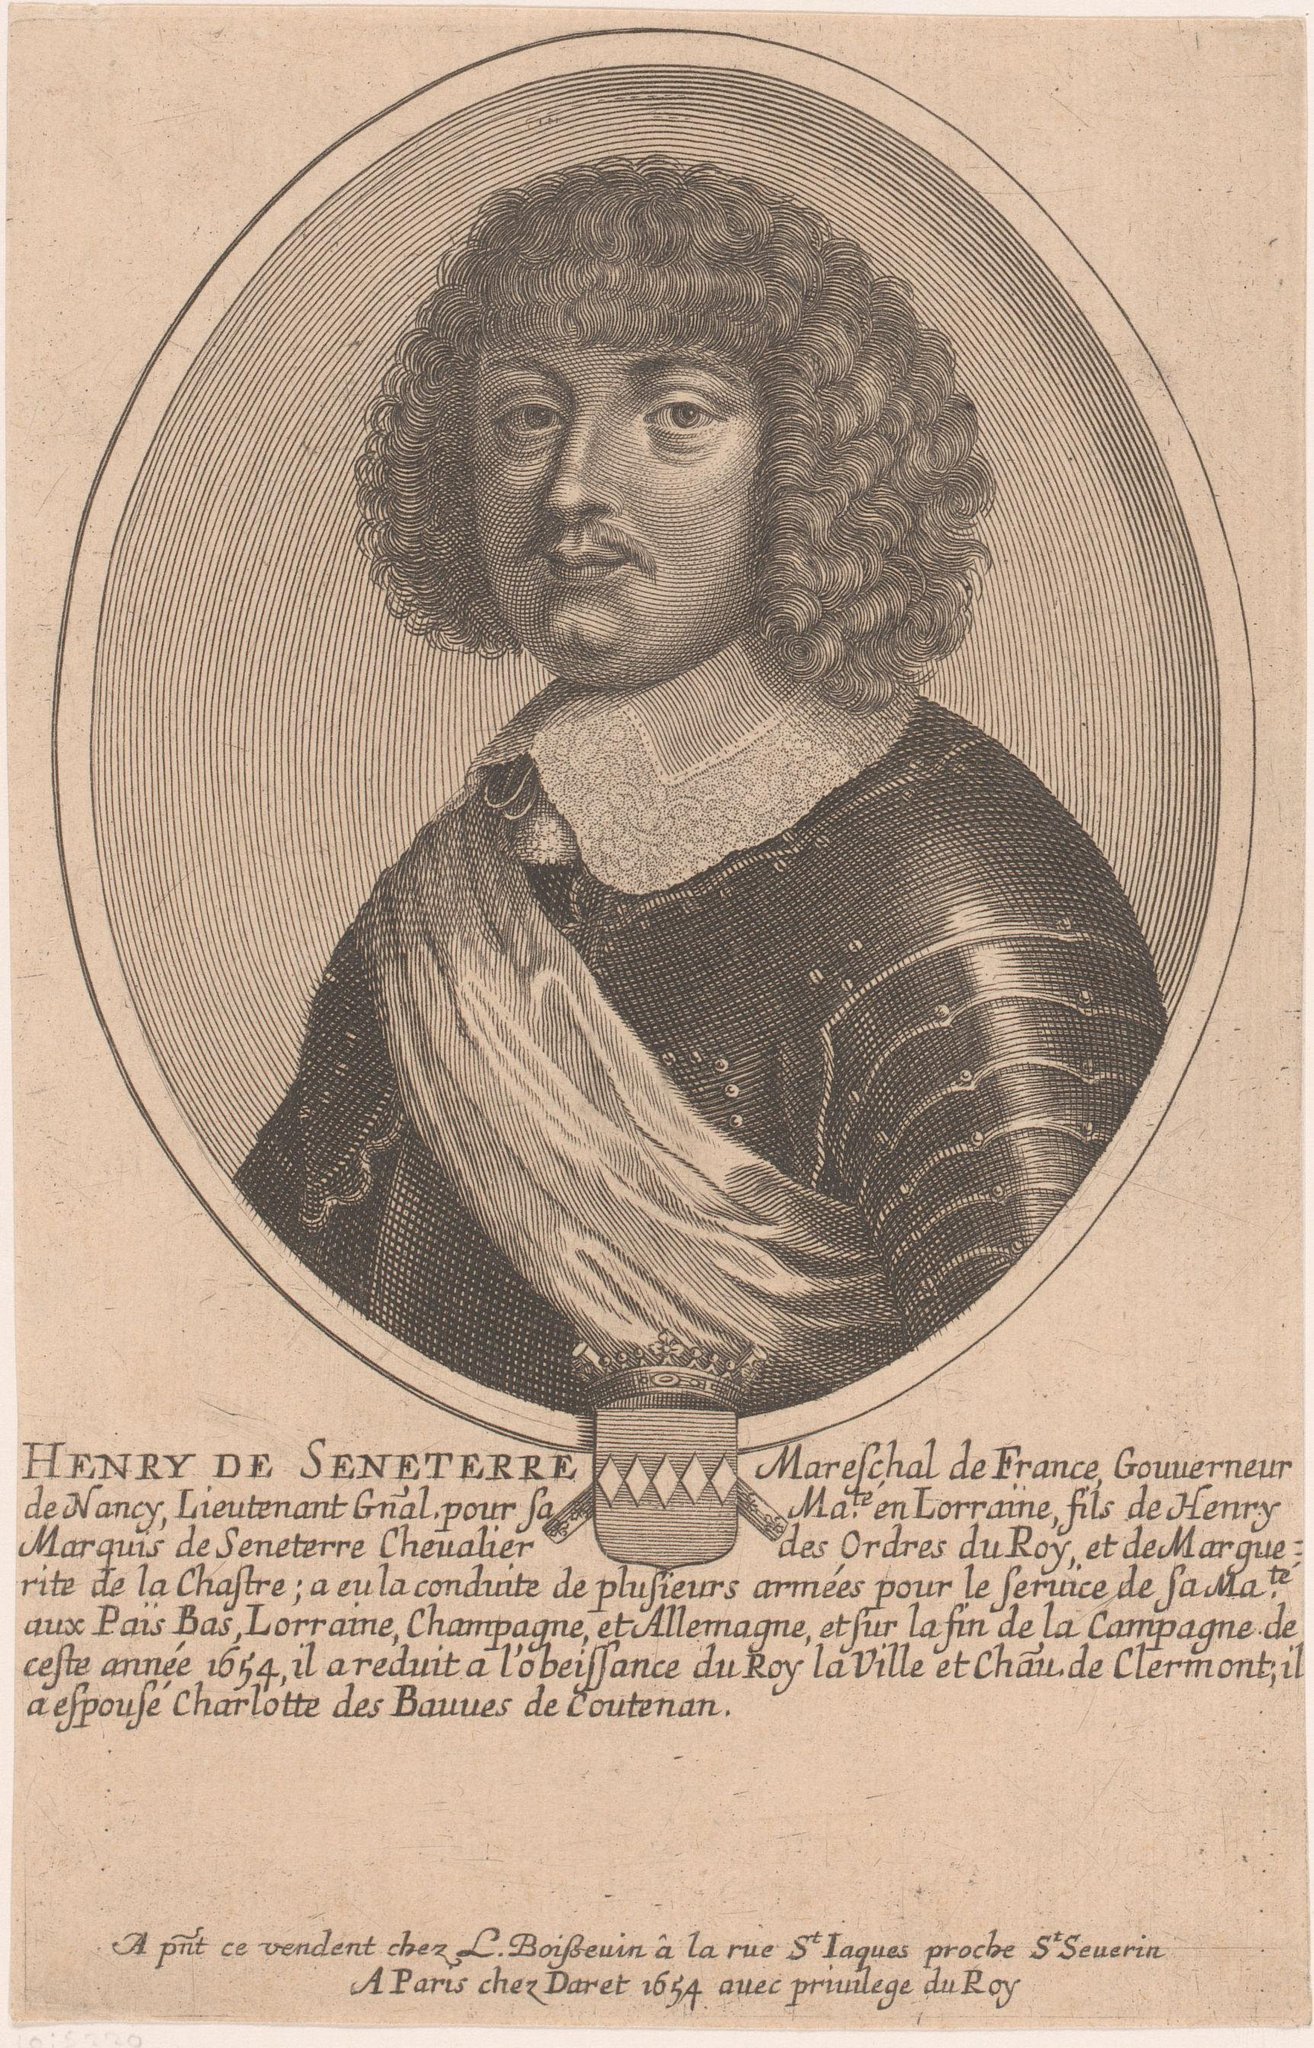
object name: print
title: Portret van Henri de La Ferté-Senneterre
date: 1654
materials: paper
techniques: engraving, etching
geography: paris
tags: politician, ornament ~ medallion, historical persons, armorial bearing, heraldry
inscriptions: collector's mark: Lugt 2228